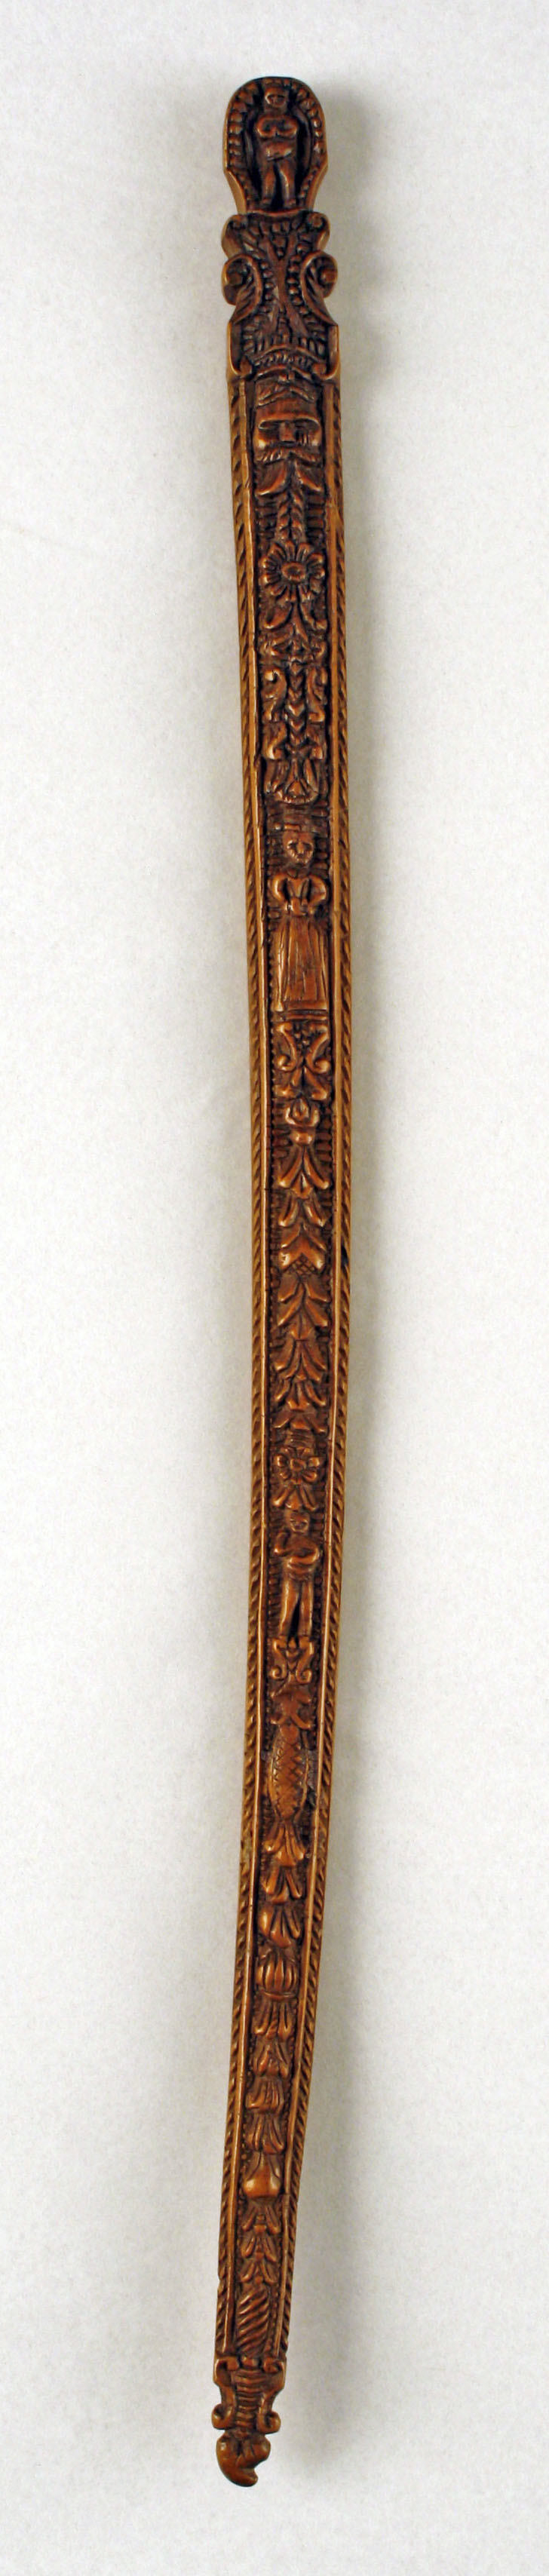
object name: busk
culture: italian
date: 1675-1725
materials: wood